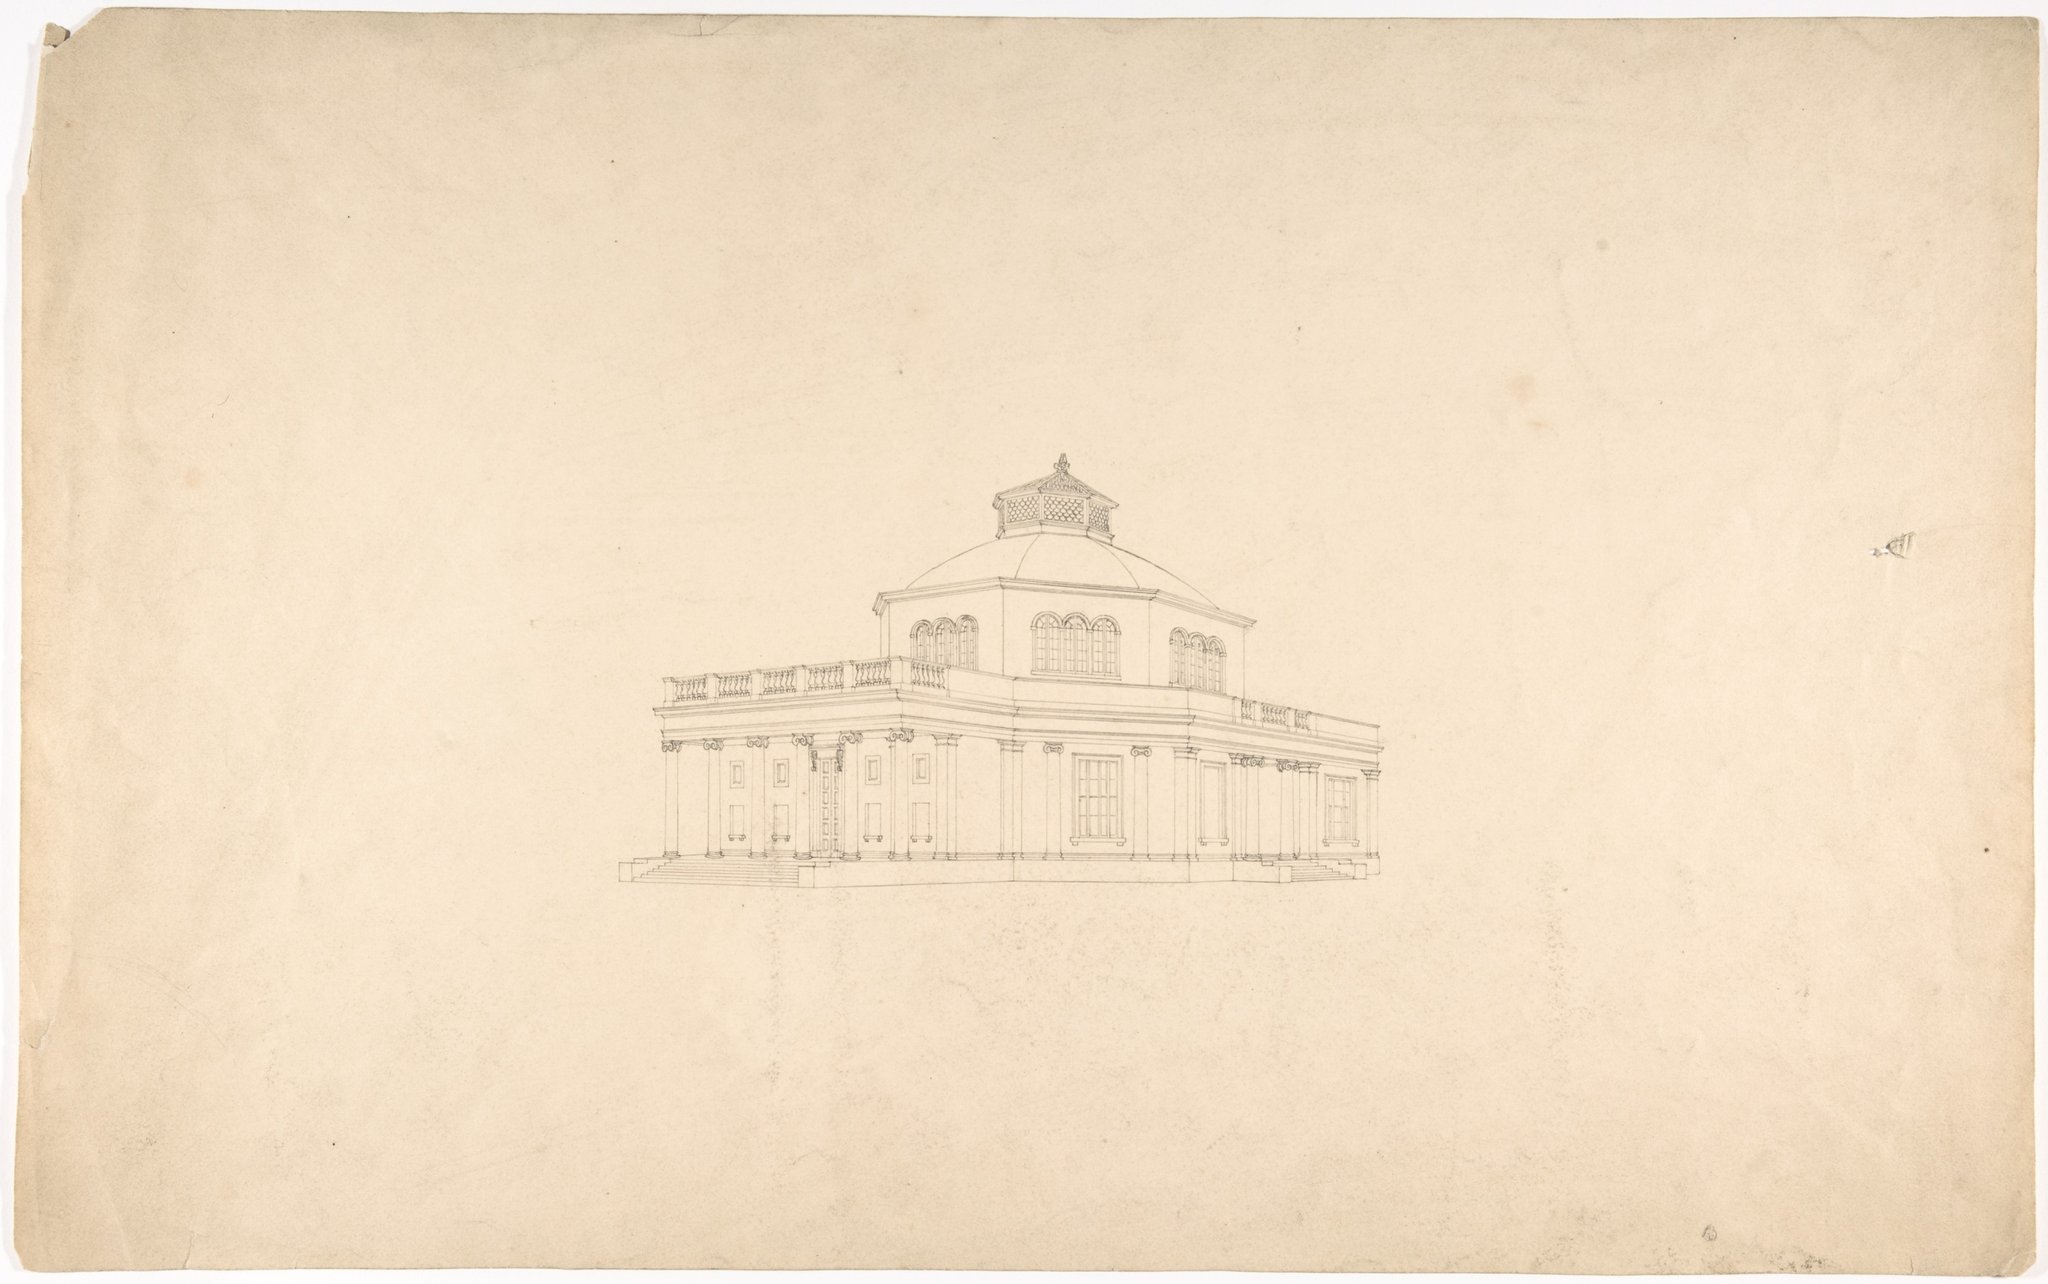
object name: drawing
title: Design for a Centrally Planned Domed Building with Porticos, Perspective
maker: anonymous, british, early 19th century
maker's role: artist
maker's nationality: british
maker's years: 1800-1850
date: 1801-1900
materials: ink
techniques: pen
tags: architecture,buildings